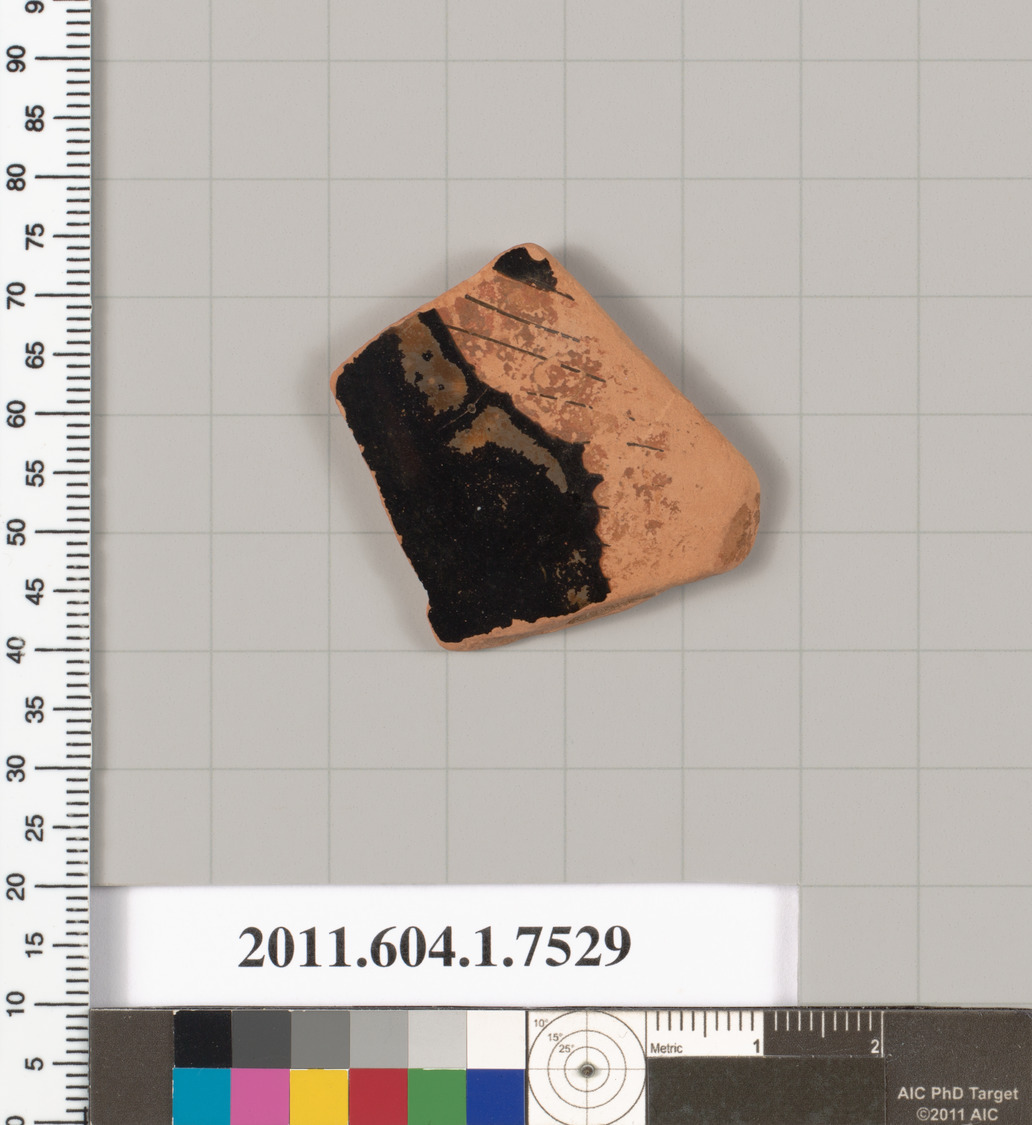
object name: kylix fragment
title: Terracotta fragment of a kylix (drinking cup)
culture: greek, attic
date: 460-450 BCE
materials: terracotta